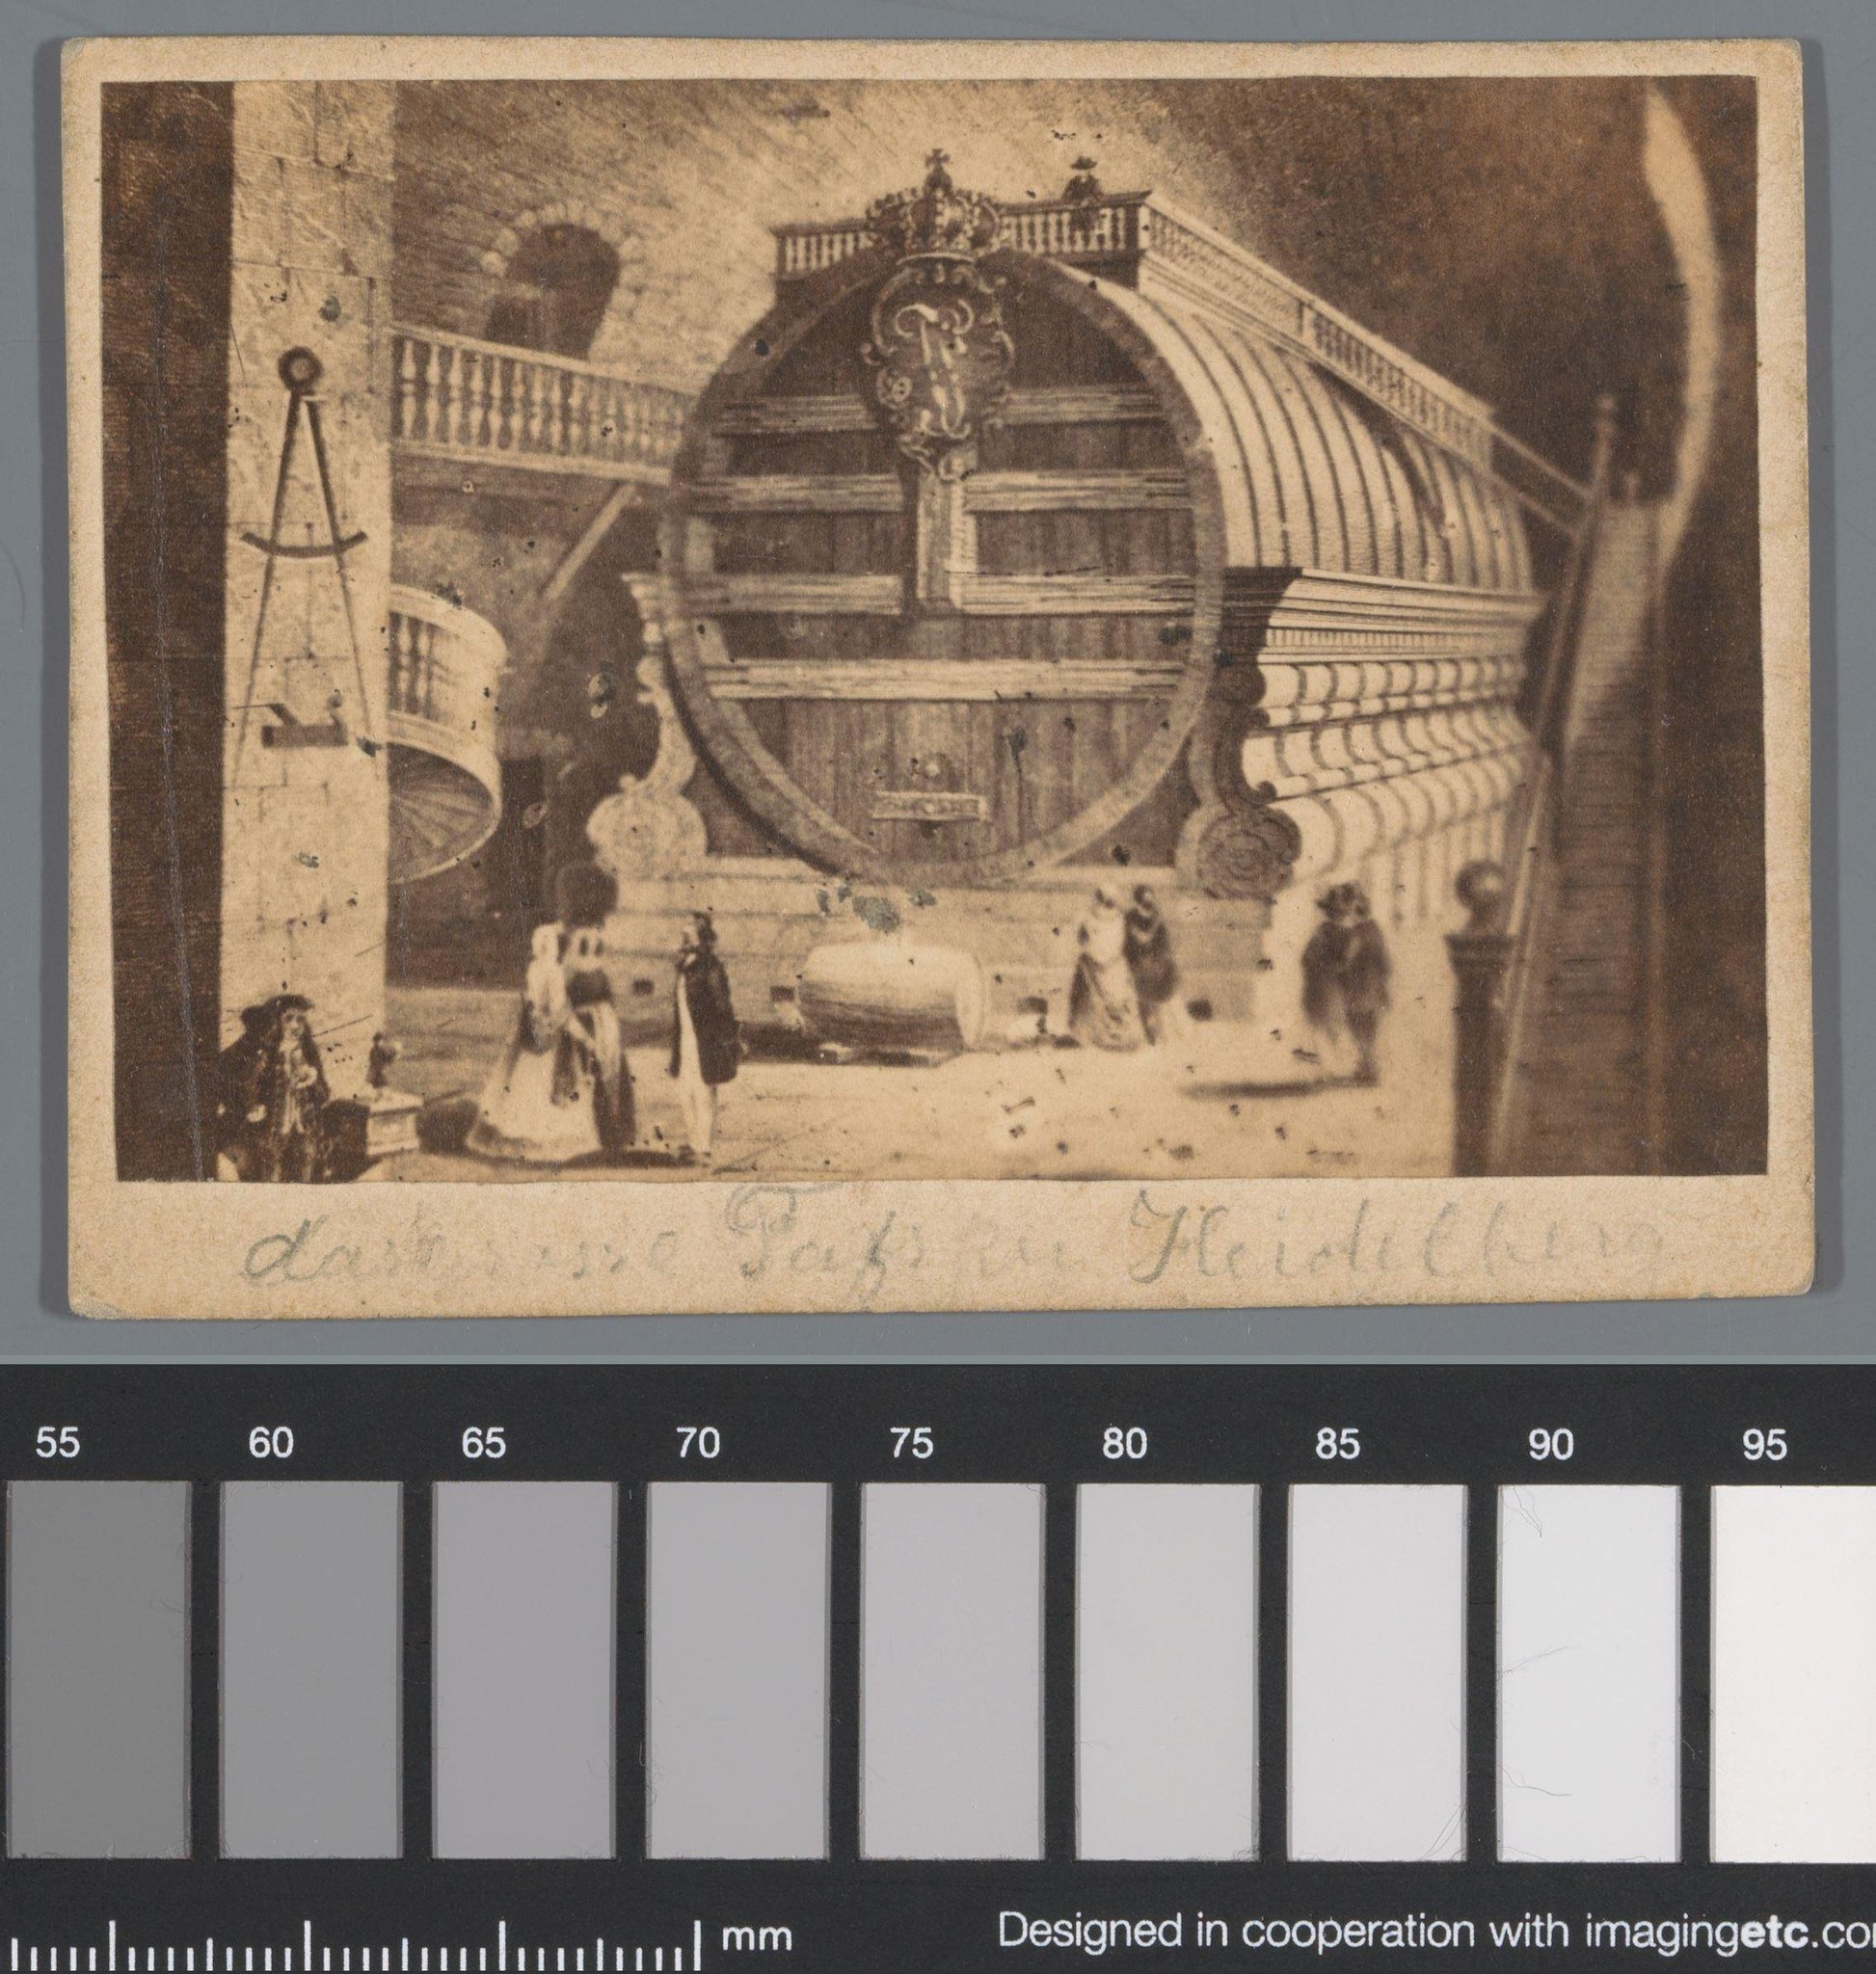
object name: photograph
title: Fotoreproductie van een prent van het grote wijnvat van Heidelberg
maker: Anonymous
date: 1860-1875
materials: cardboard, paper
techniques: albumen print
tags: wooden container: barrel, cask, bucket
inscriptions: inscription: ‘36,000/ fleschen Wein/ ist 2 mal voll/ [...]’